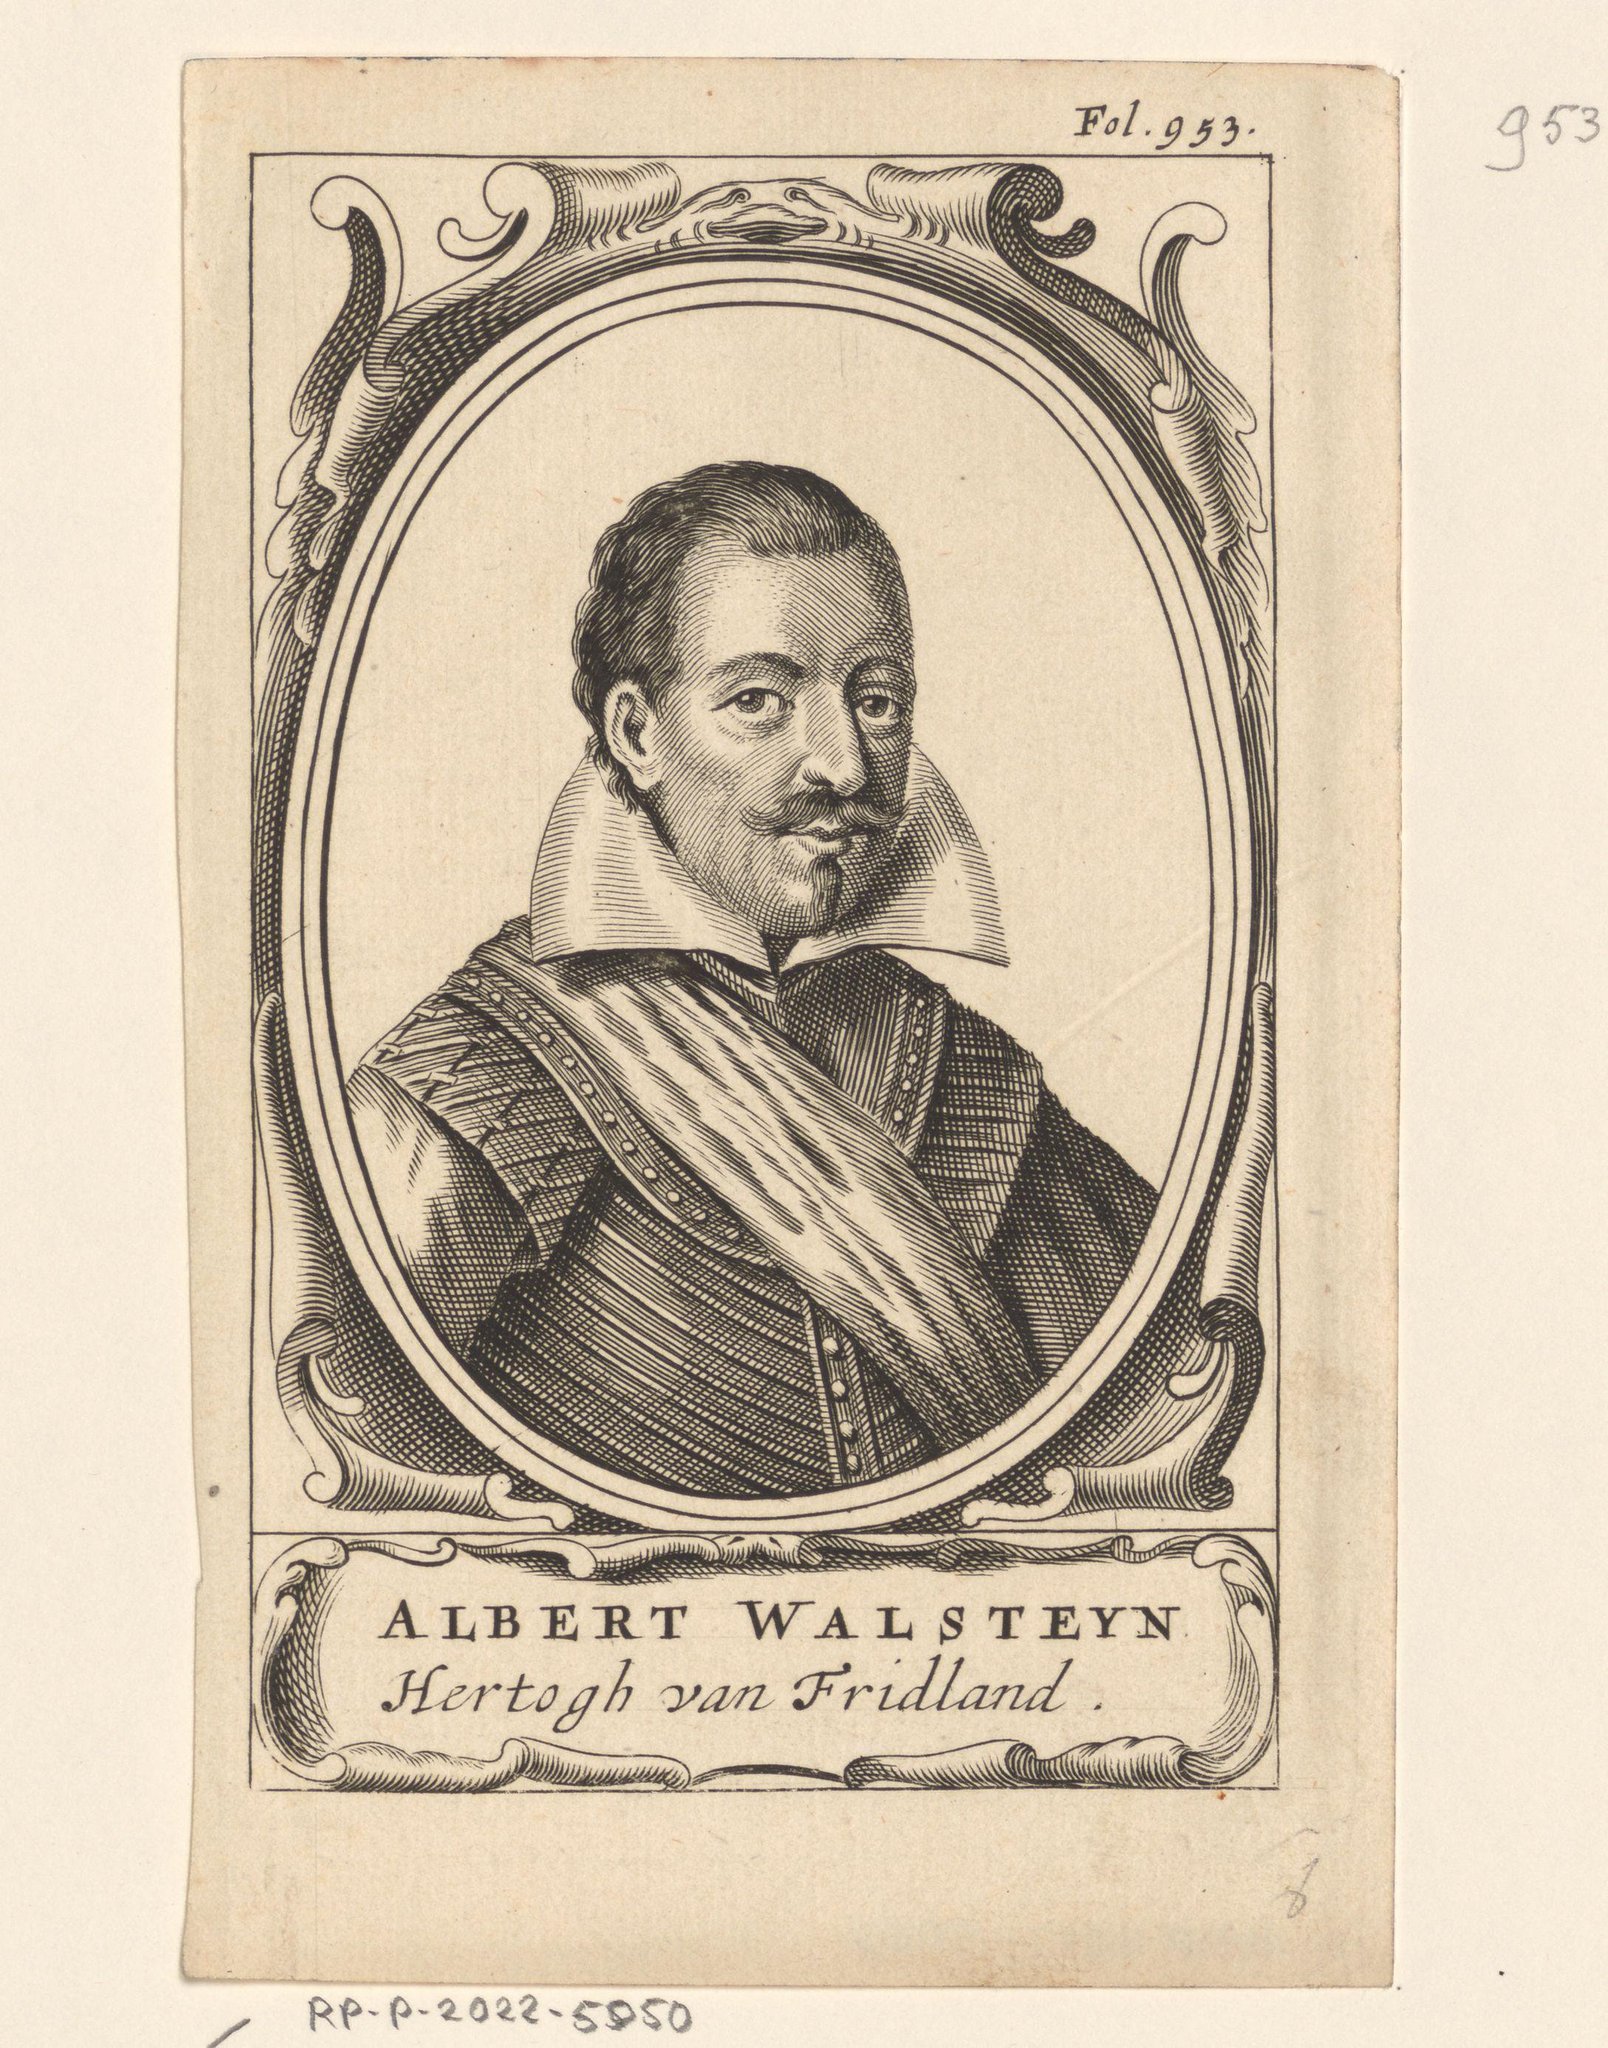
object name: book illustration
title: Albert Walsteyn Hertogh van Fridland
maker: Anonymous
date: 1669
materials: paper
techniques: engraving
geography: netherlands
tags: commander-in-chief, general, marshal, historical persons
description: Prent uit: Corput, Abraham van den. De goddelicke vierschare, dat is ontdeckinge der hemelsche oordelen (…). Amsterdam: Johannes Janssonius van Waesberge I en weduwe Elizee Weijerstraet, 1669, dl. 4, p. 953.